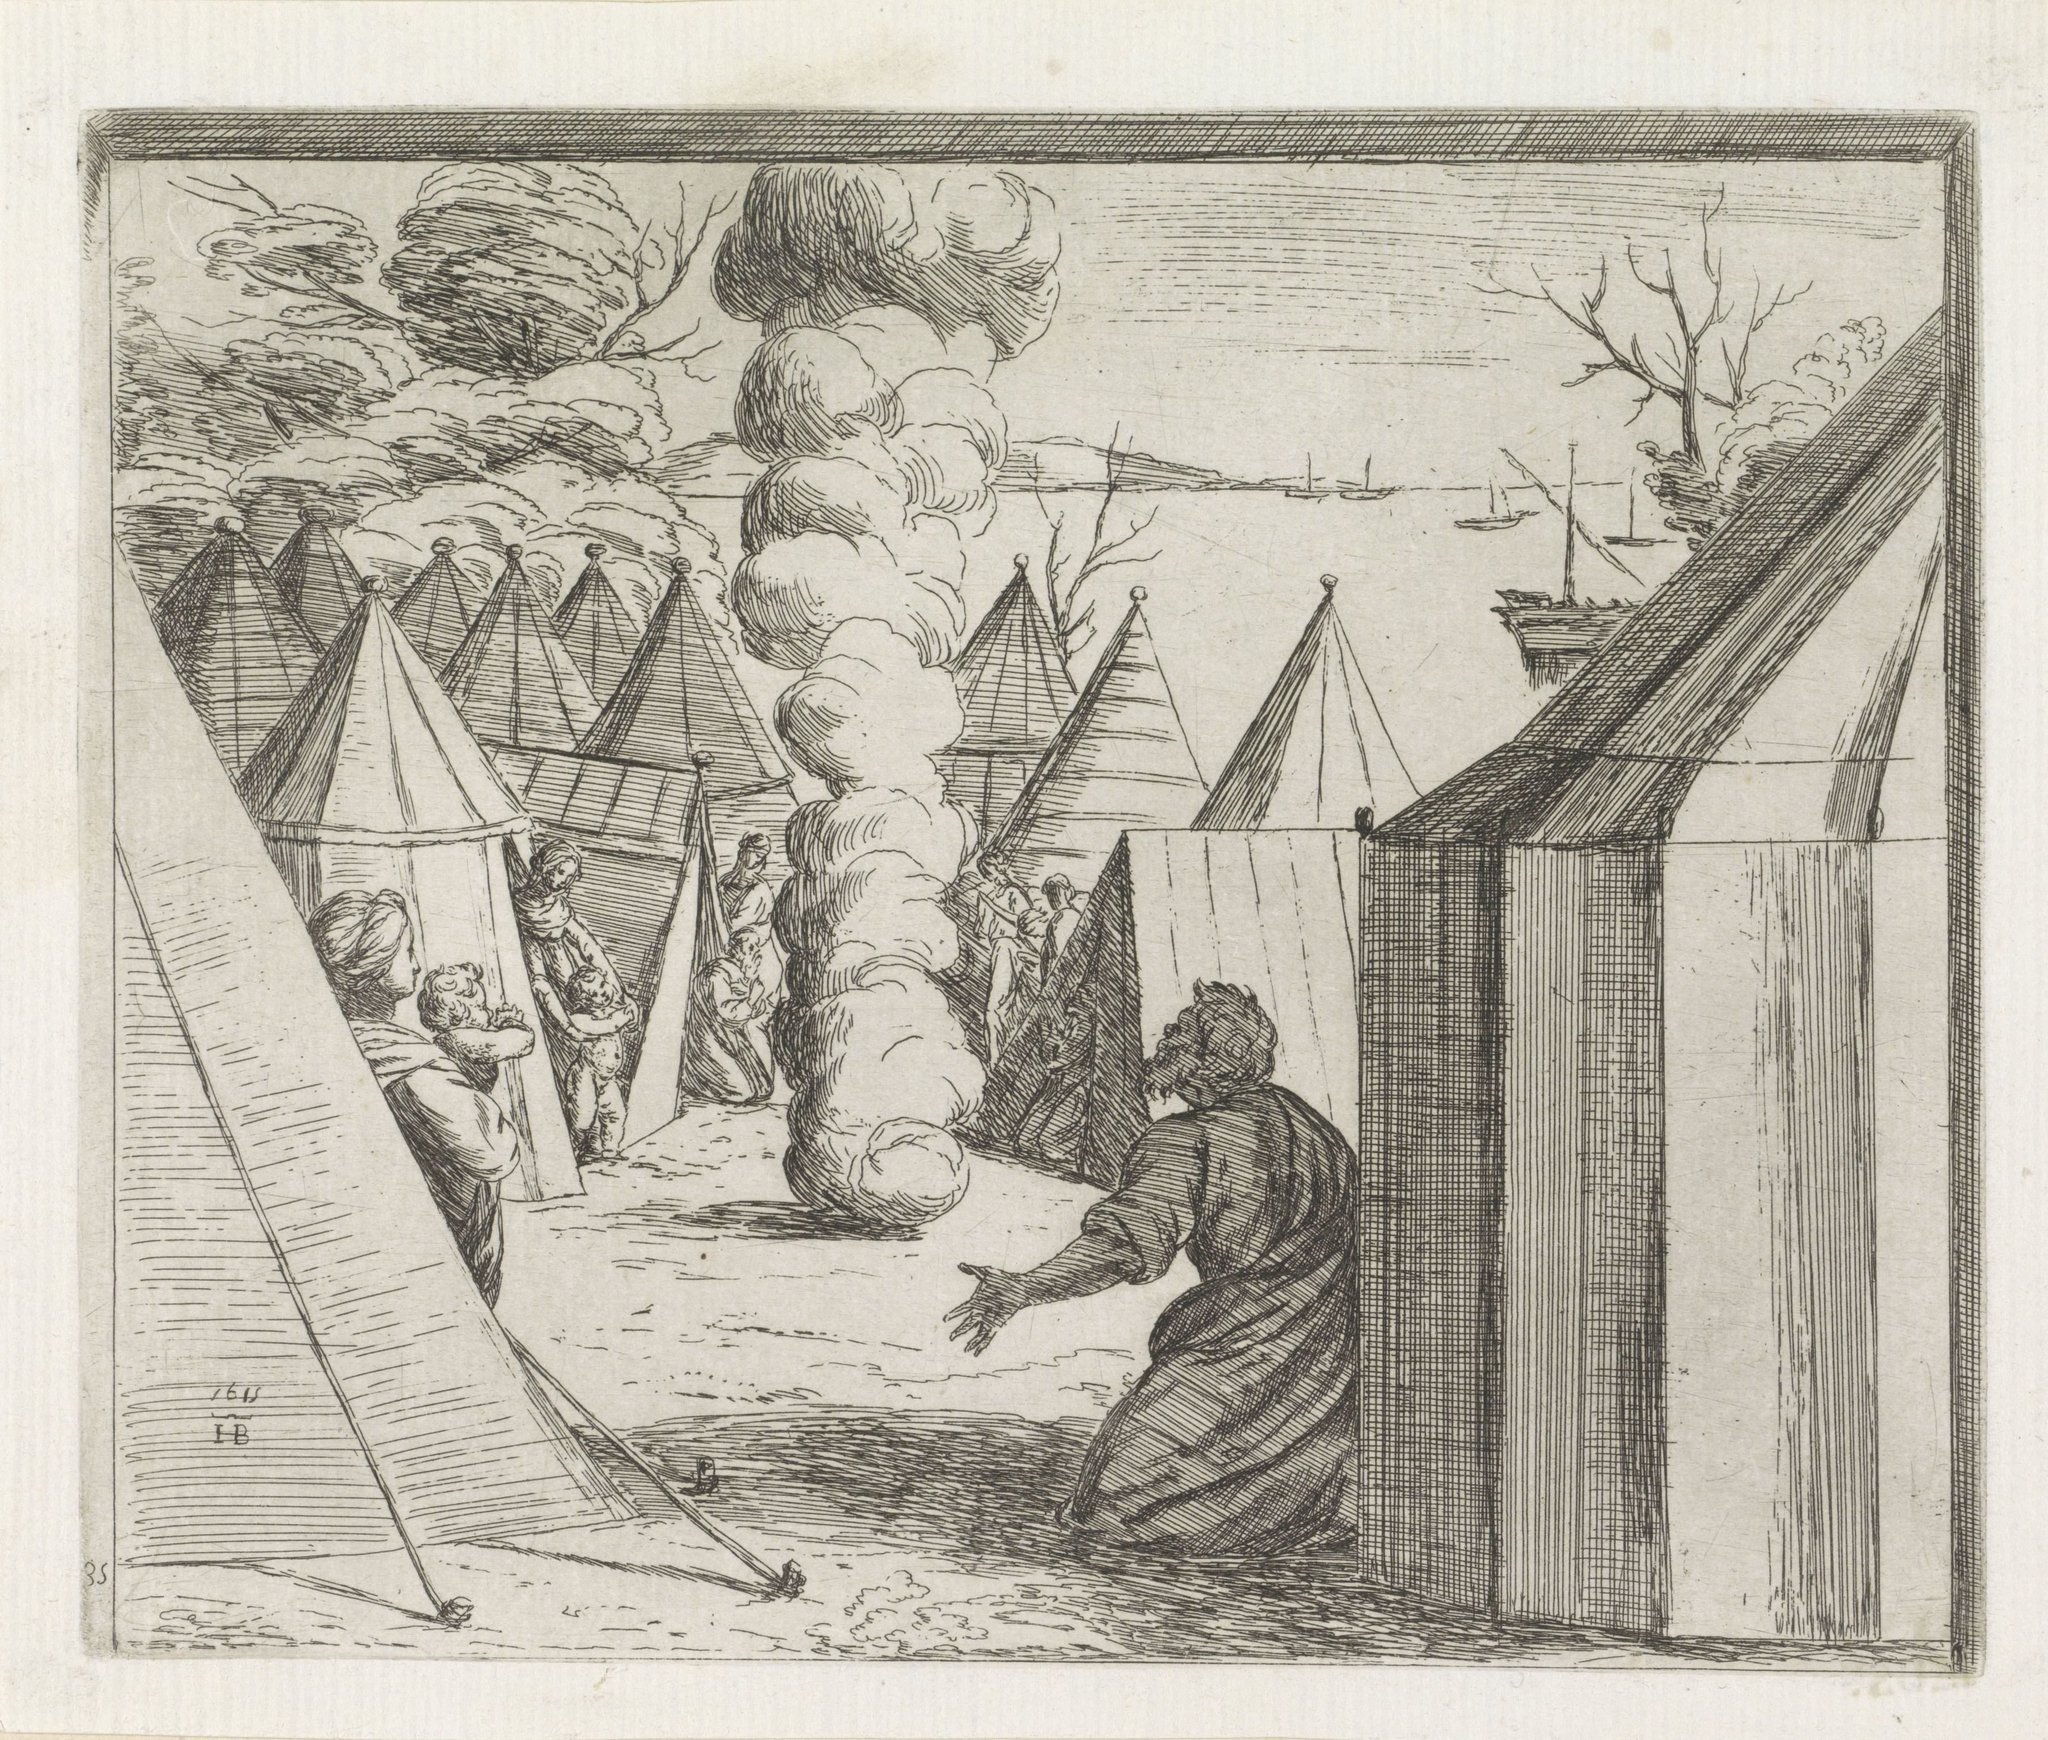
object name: print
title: God verschijnt aan Mozes in een rookkolom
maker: orazio borgianni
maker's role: print maker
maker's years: 1578-1616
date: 1615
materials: paper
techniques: etching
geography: vatican city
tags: god comes down in the pillar of cloud at the door of the tabernacle and rebukes aaron and miriam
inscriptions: collector's mark: Lugt 2165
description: Prent uit een reeks van 52 prenten naar schilderingen in de Loggia van Rafaël in het Vaticaan.